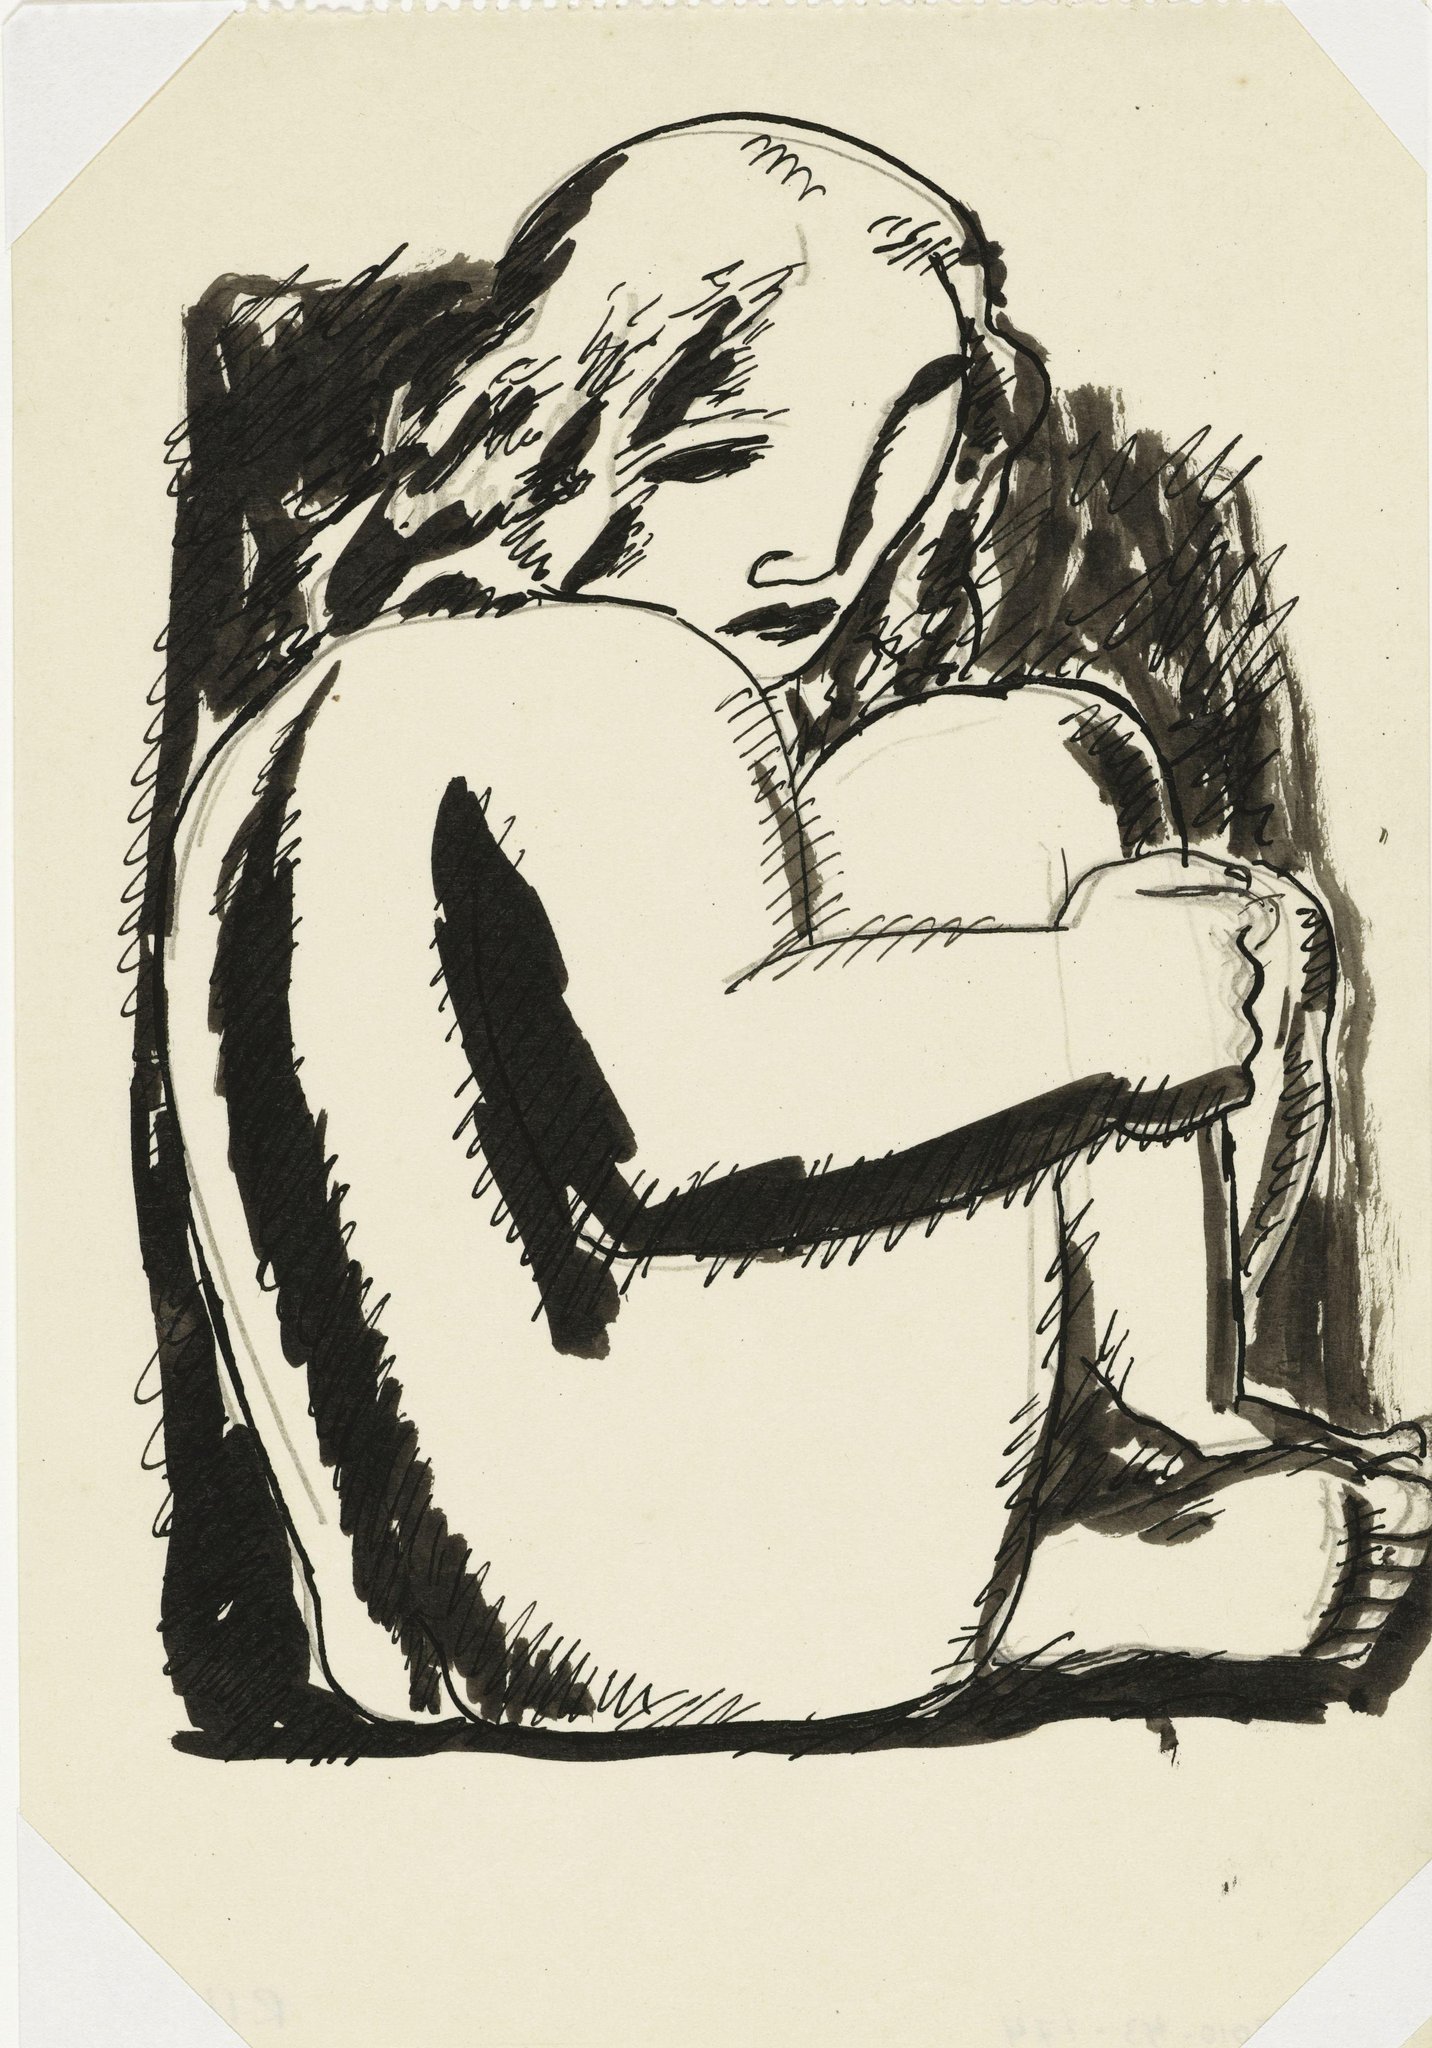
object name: drawing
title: Naakte zittende vrouw met opgetrokken knieën (schets)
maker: leo gestel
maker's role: draughtsman, print maker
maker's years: 1881-1941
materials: ink, paper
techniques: brush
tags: sitting figure - aa - female human figure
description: Naakte zittende vrouw met opgetrokken knieën, de amandelvormige ogen met zwart ingevuld, diagonale arceringen bij de omtrekken van de lichaamsdelen.